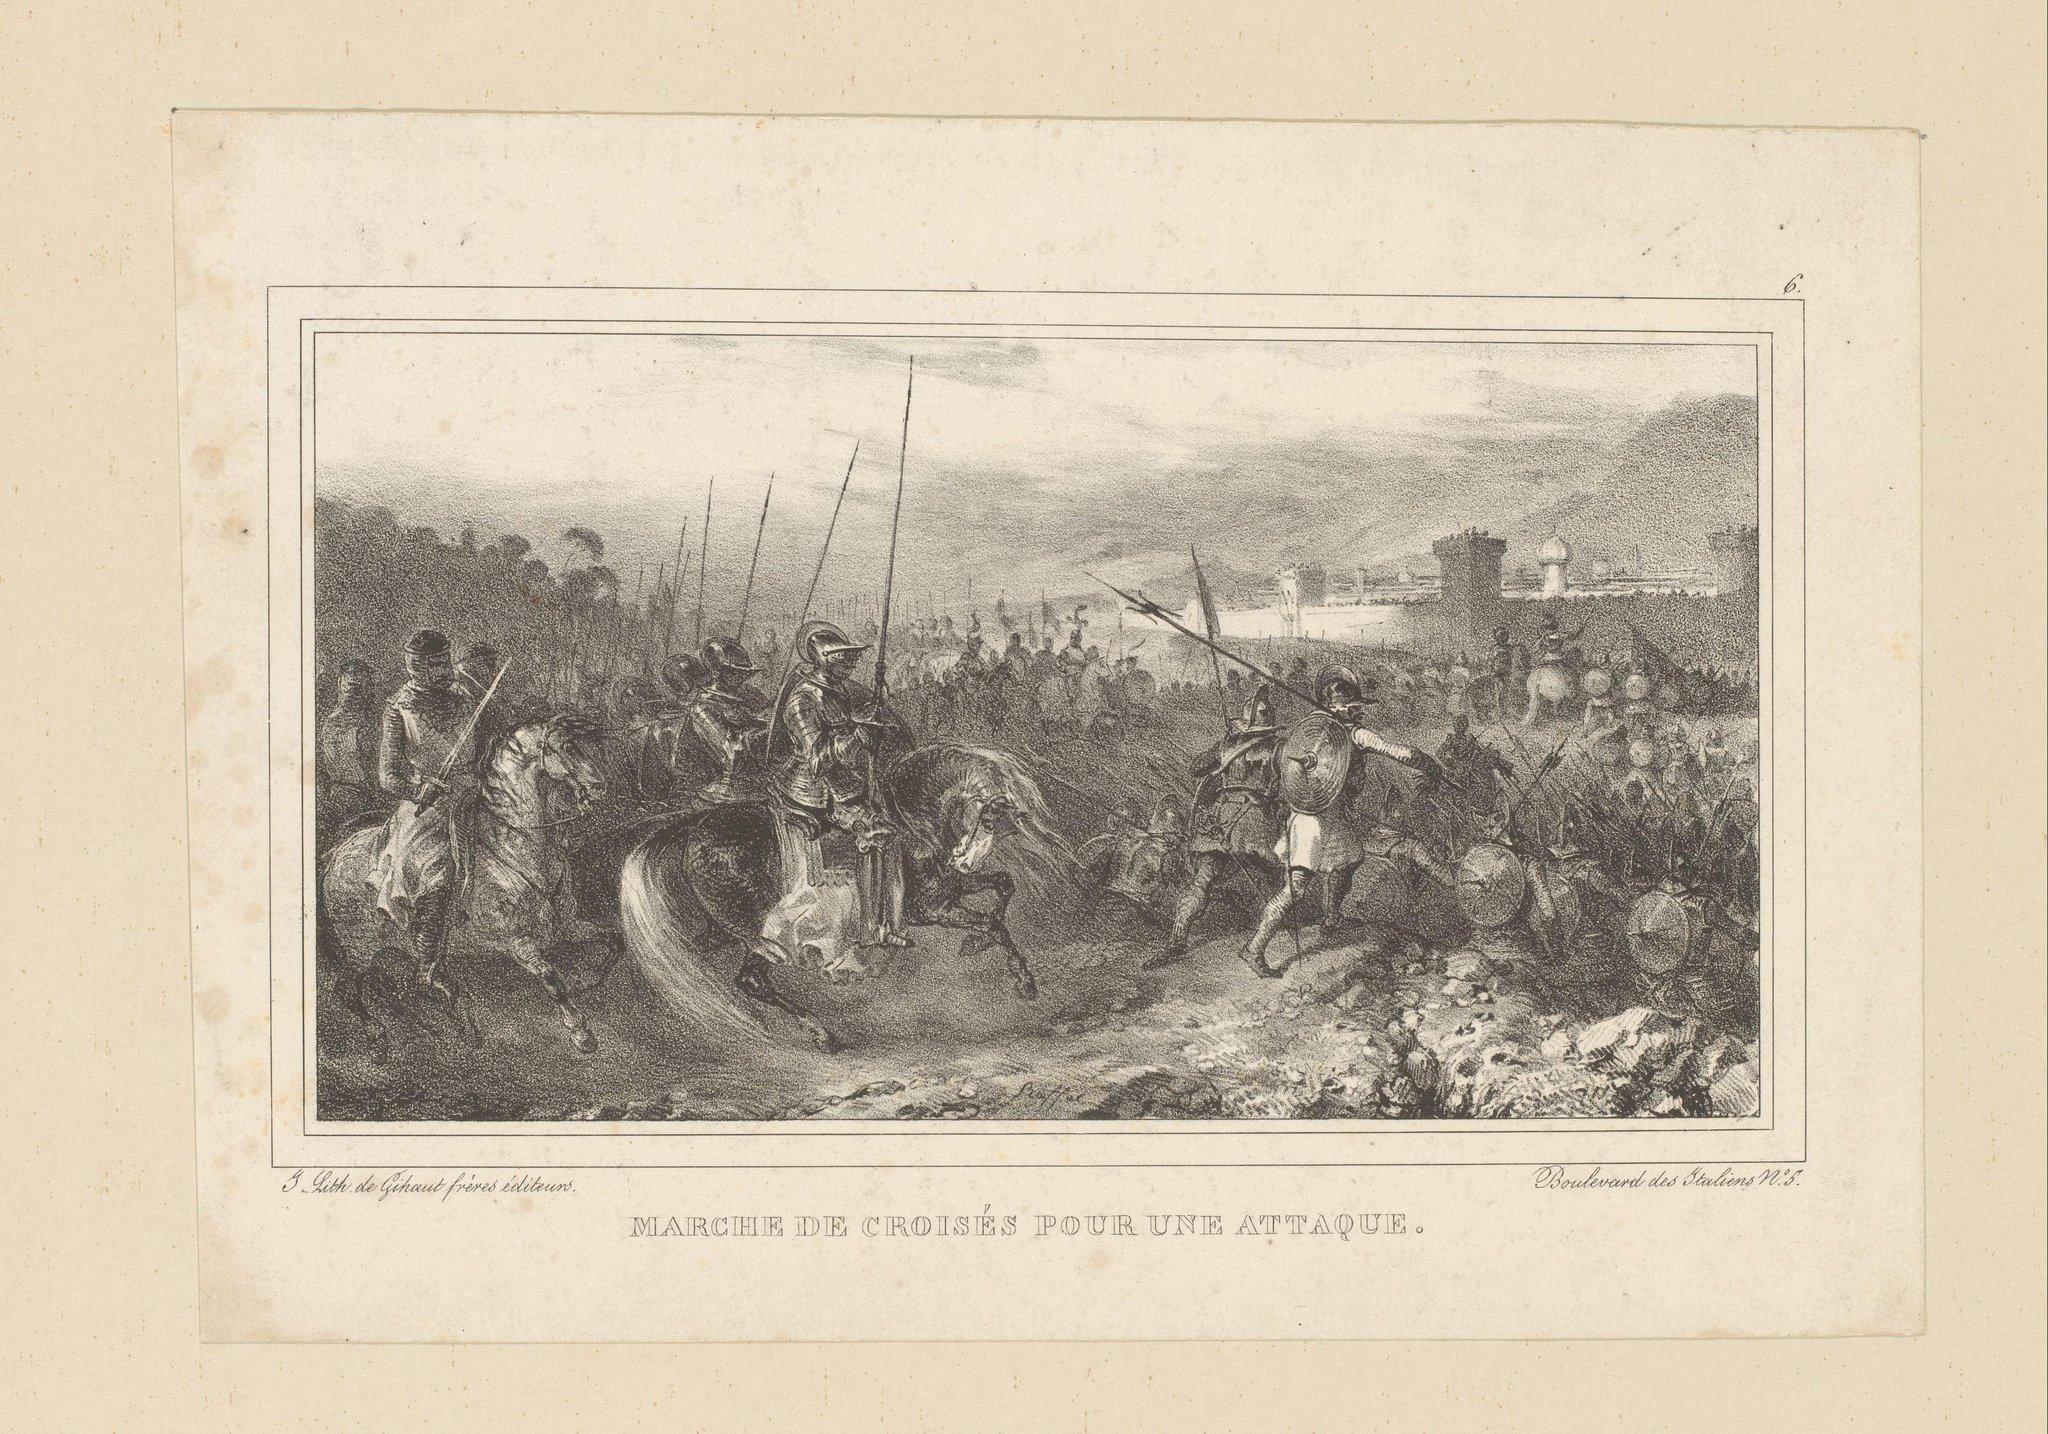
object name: print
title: Marche de croisés pour une attaque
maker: denis auguste marie raffet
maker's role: draughtsman, print maker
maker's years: 1804-1860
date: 1830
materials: paper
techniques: lithograph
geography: paris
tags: riding a horse, ass, or mule; rider, horseman, militant proselytizing: religious war, crusade, etc., the soldier; the soldier's life, charge ~ battle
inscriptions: collector's mark: Lugt 2760, collector's mark: Lugt 2228